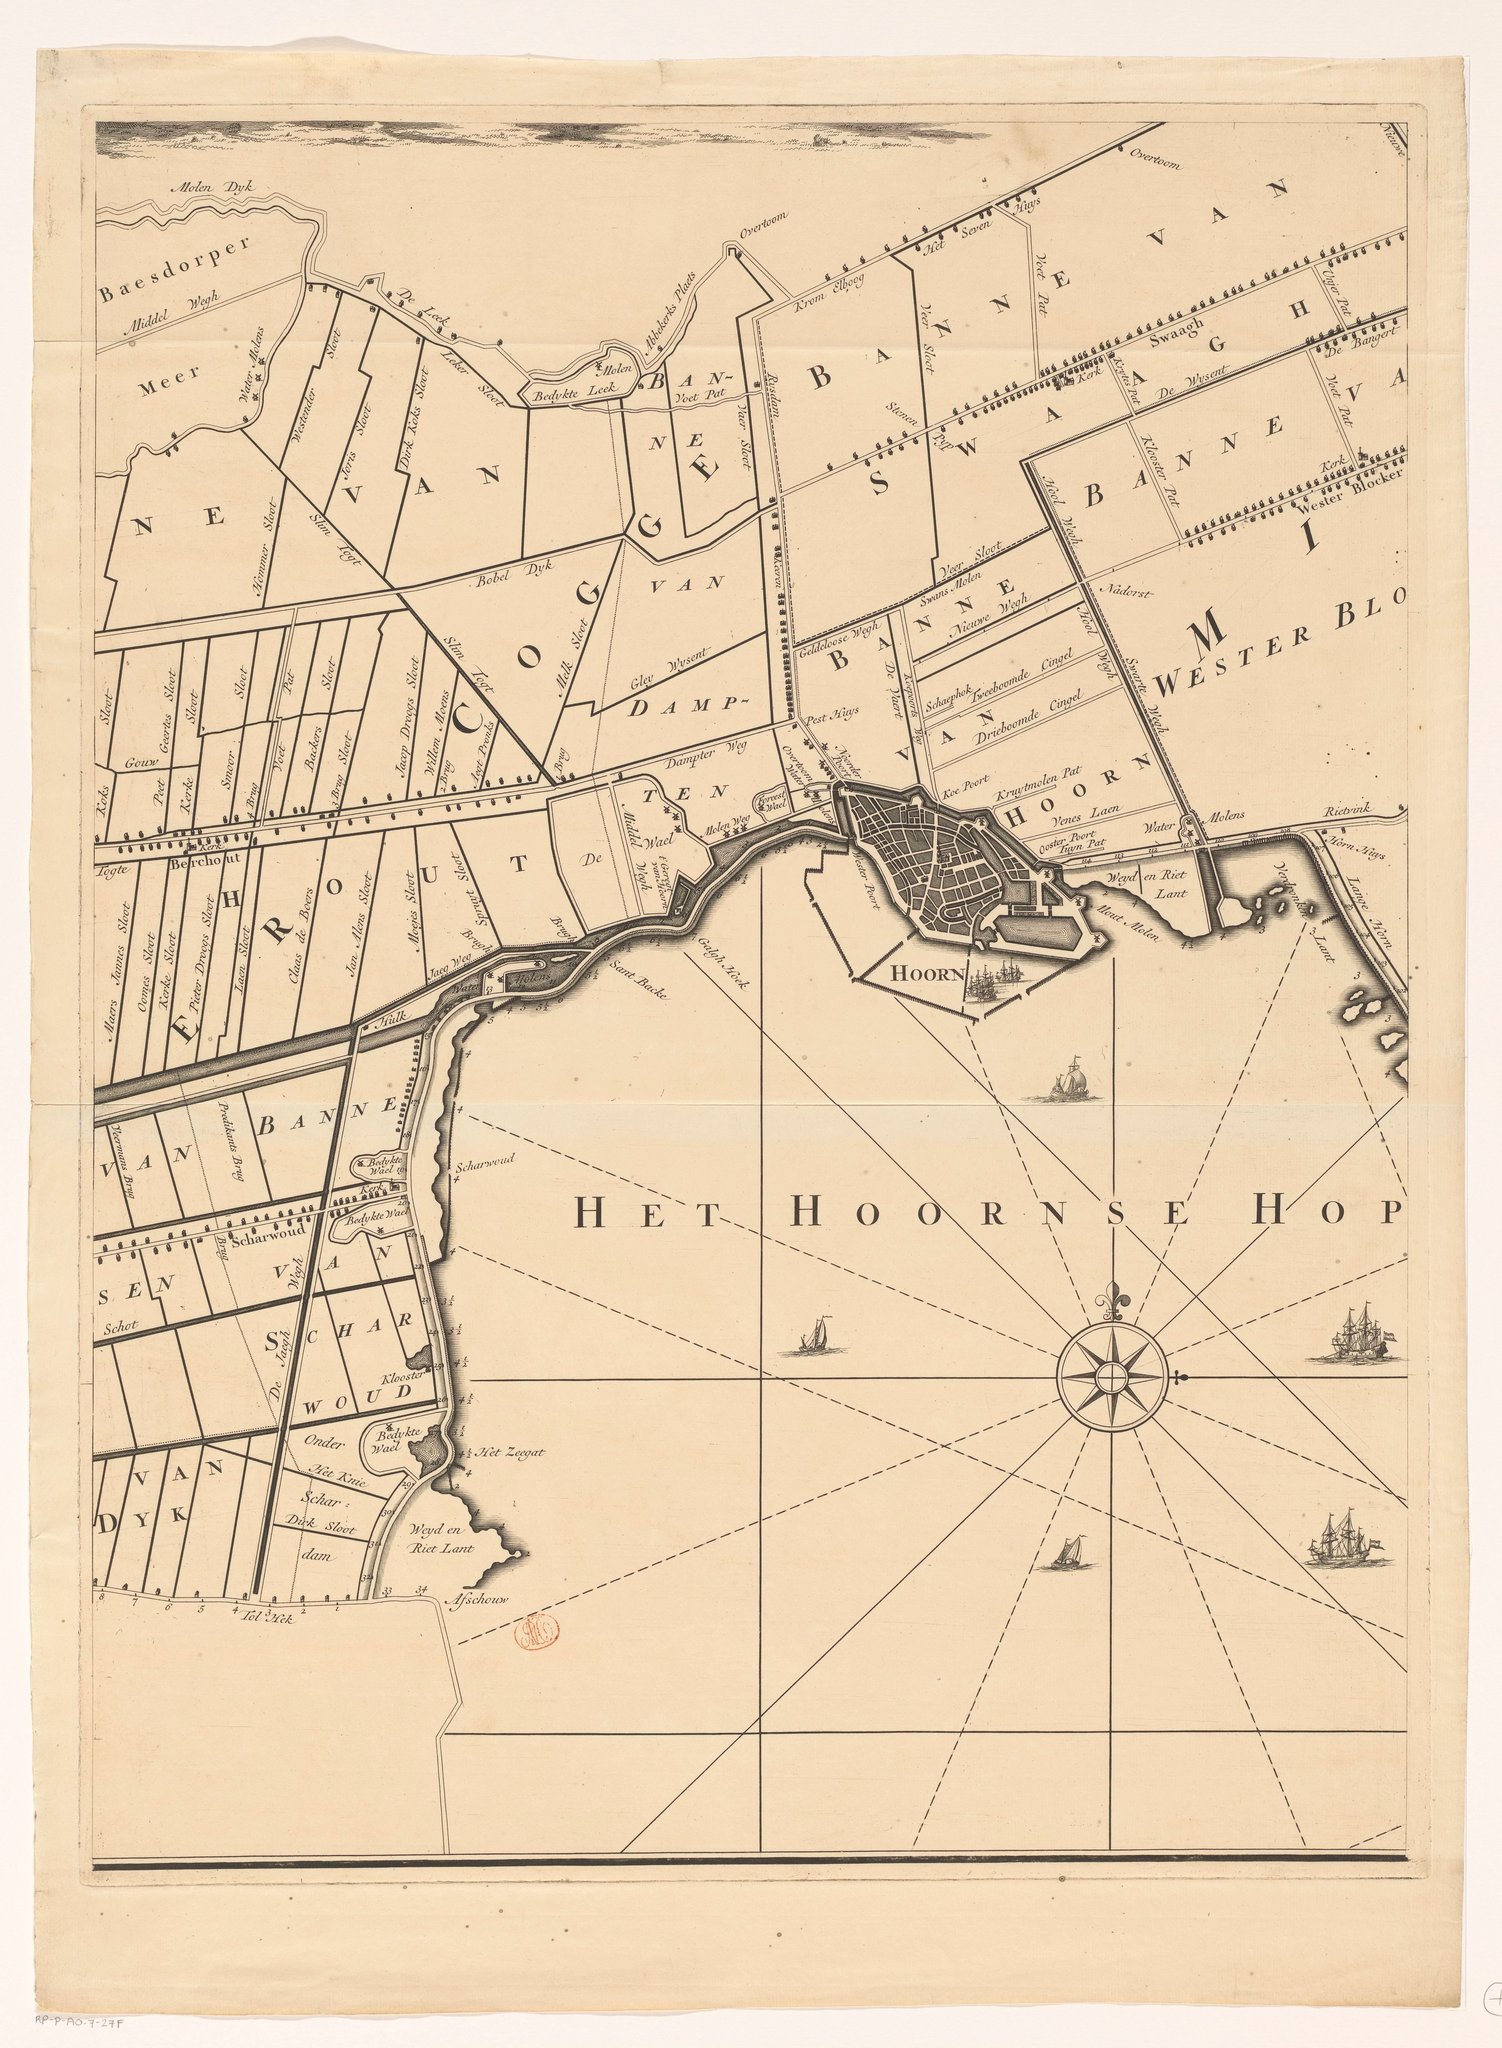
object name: map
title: Nieuwe kaarte van het dyckgraafschap van Dregterlandt. MDCCXXIII.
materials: paper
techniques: engraving, etching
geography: amsterdam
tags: maps of separate countries or regions, polder, reclaimed land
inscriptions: collector's mark: Lugt 195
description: Deel (tweede van onder) van een kaart van het dijkgraafschap Drechterland.